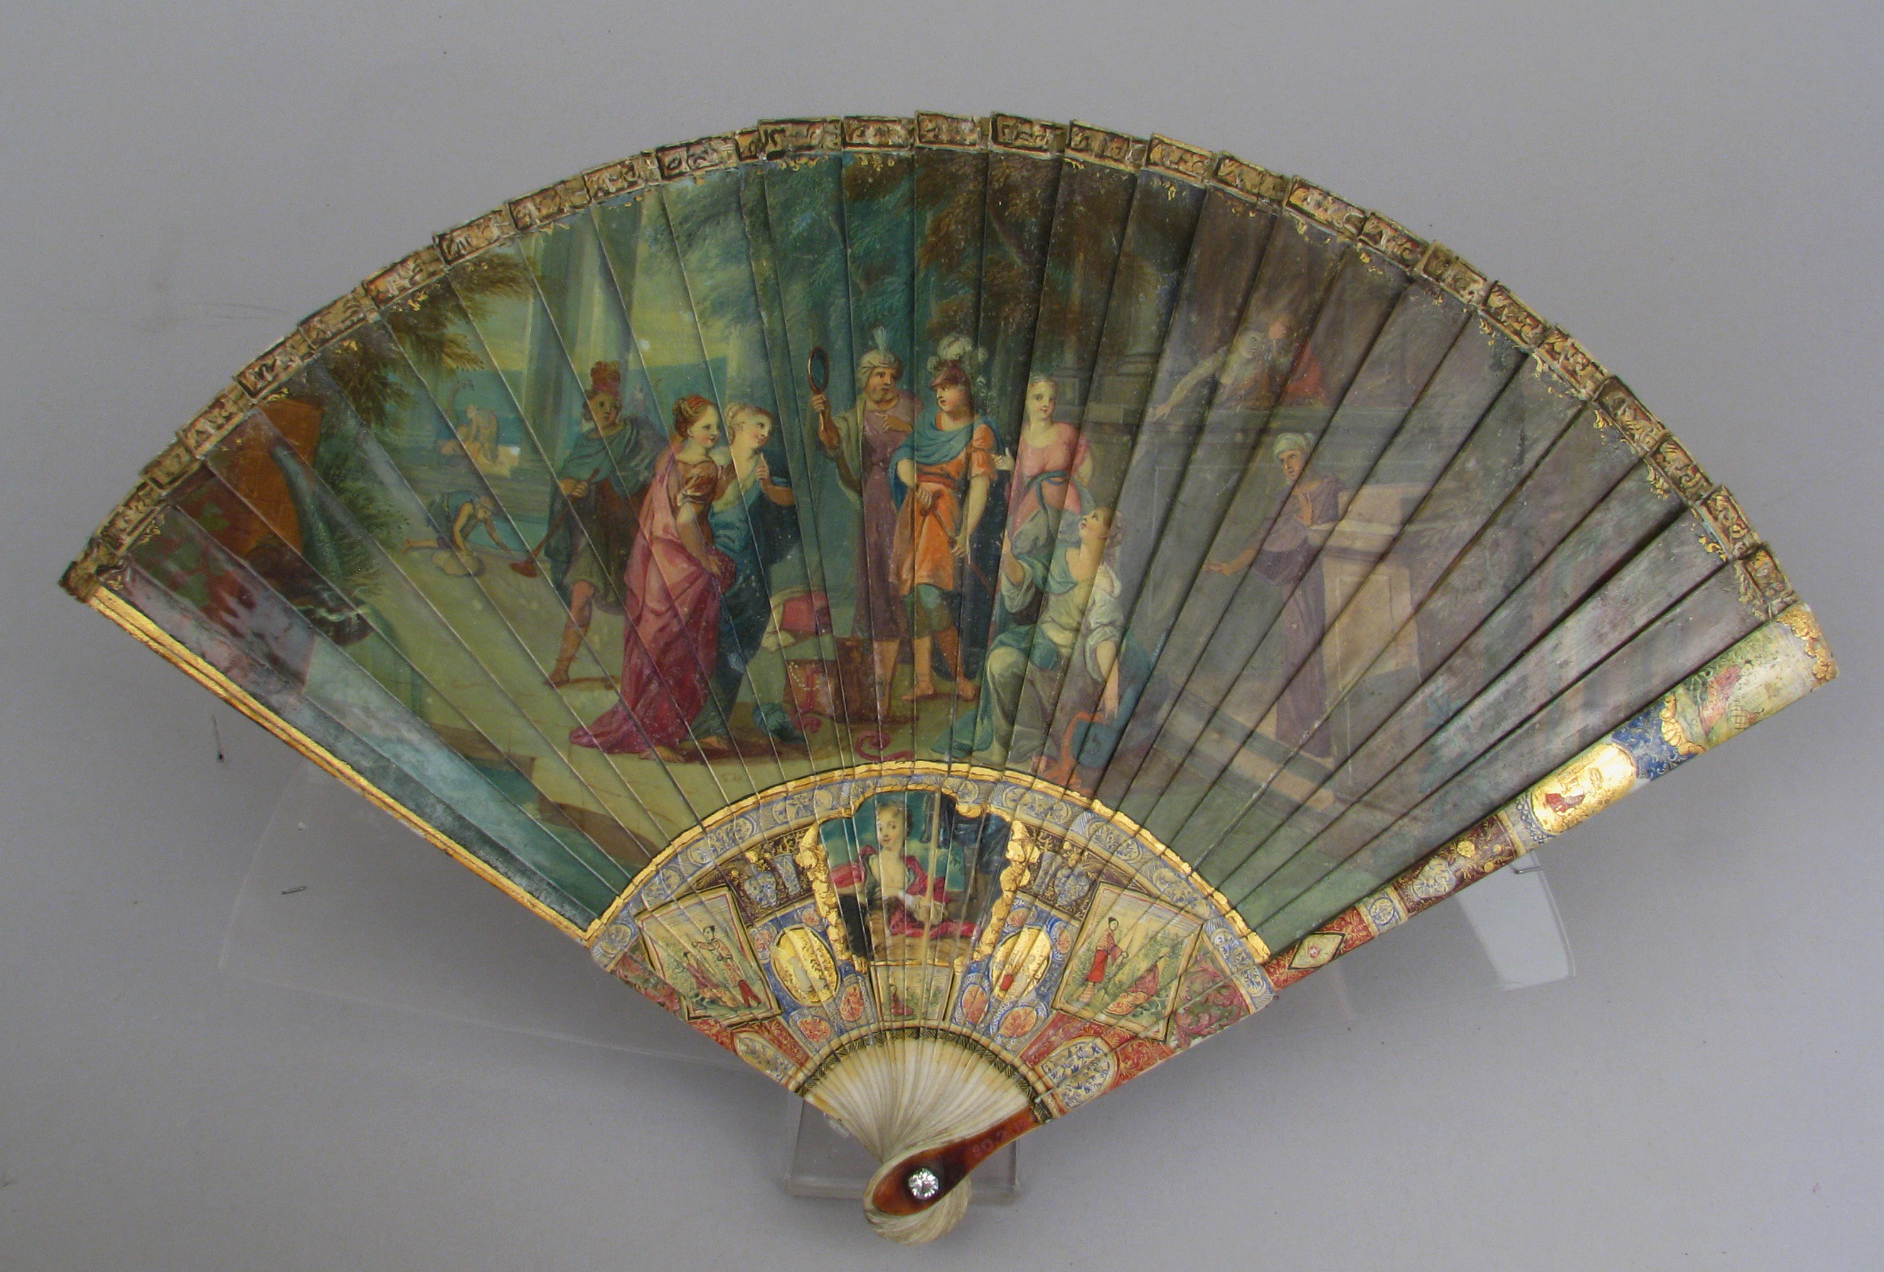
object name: fan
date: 1700-1723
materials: ivory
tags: men,women